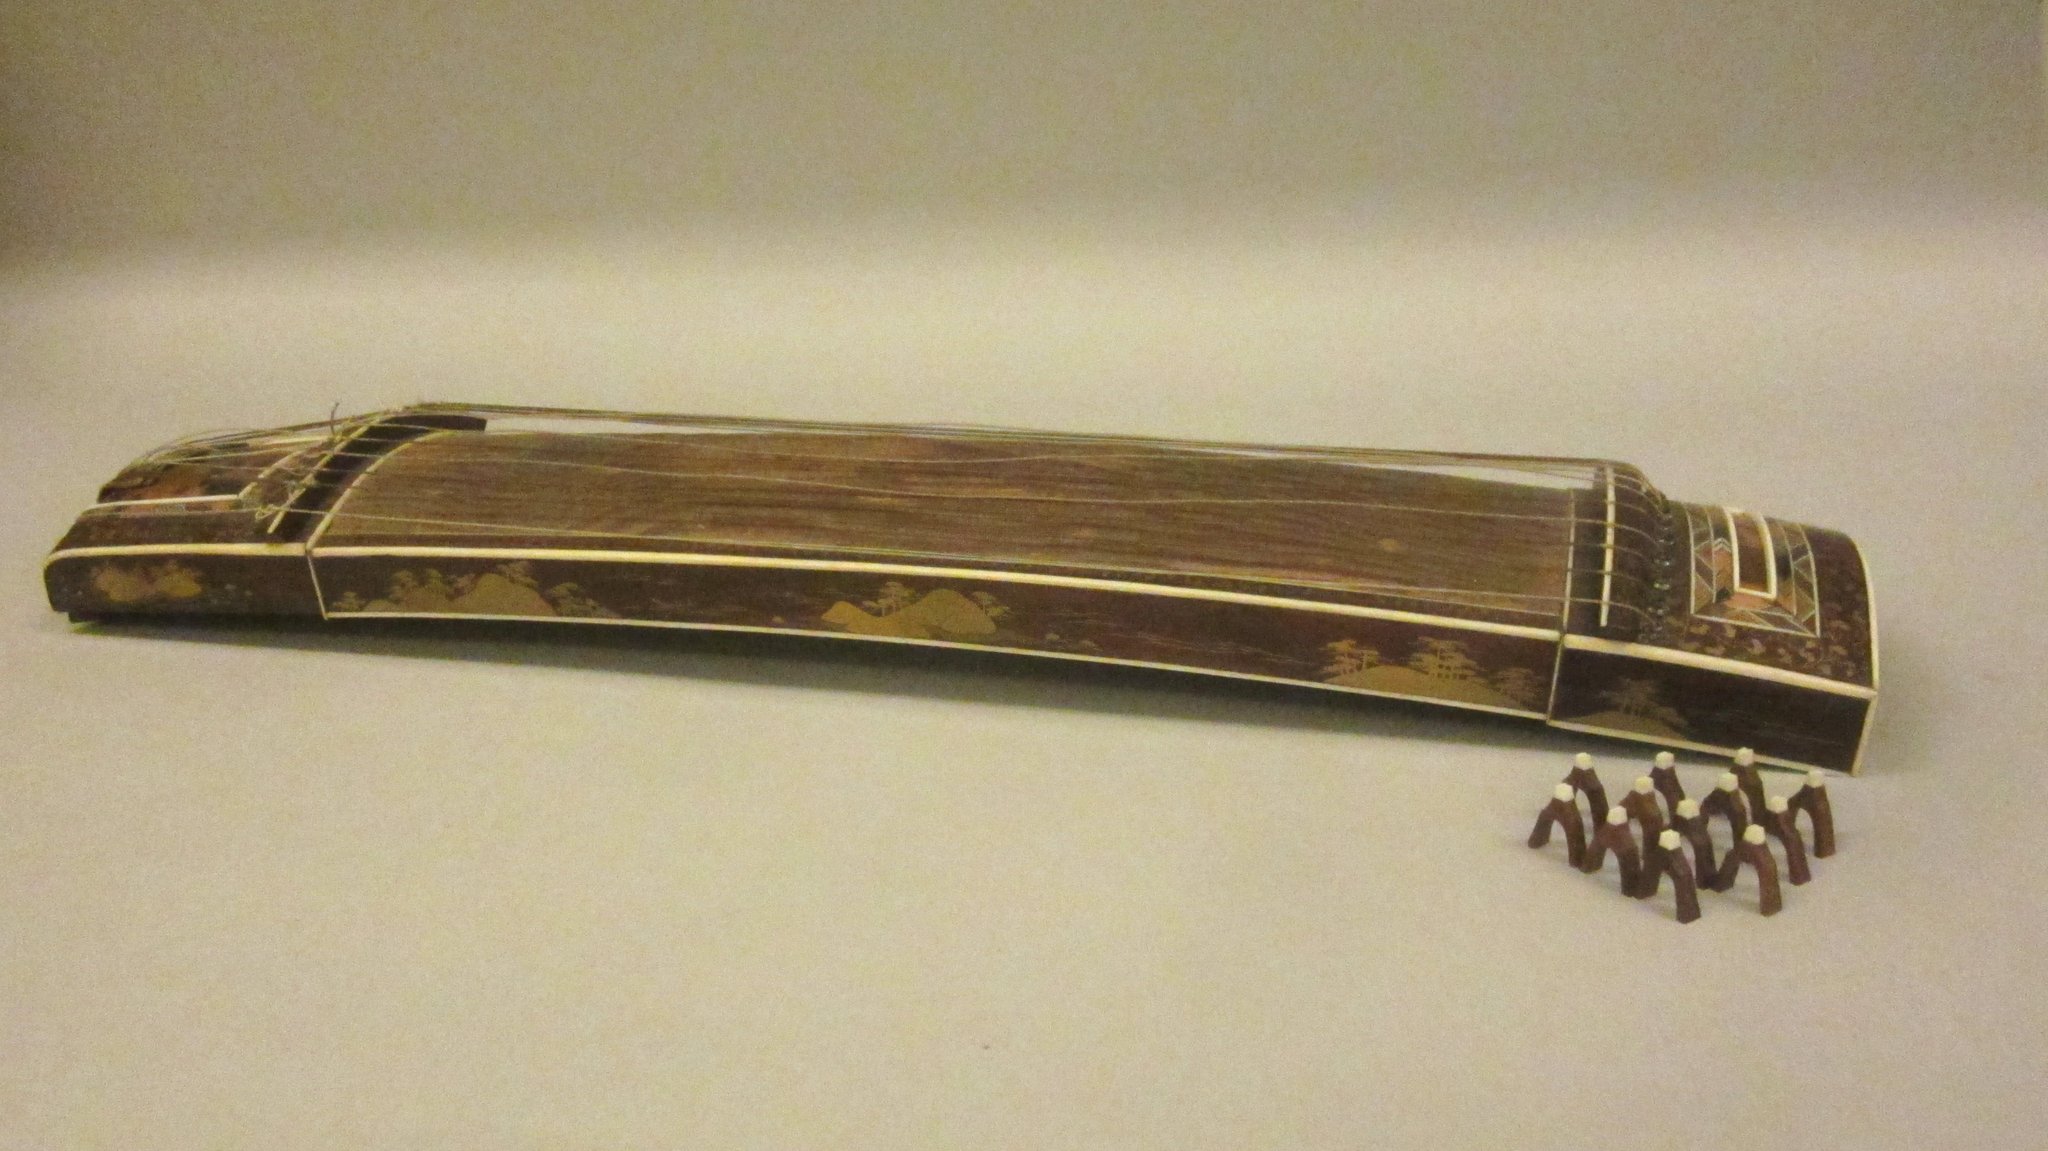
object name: miniature koto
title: Miniature Koto (箏)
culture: japanese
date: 1834-1900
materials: ivory, lacquer, metal, silk, wood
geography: japan